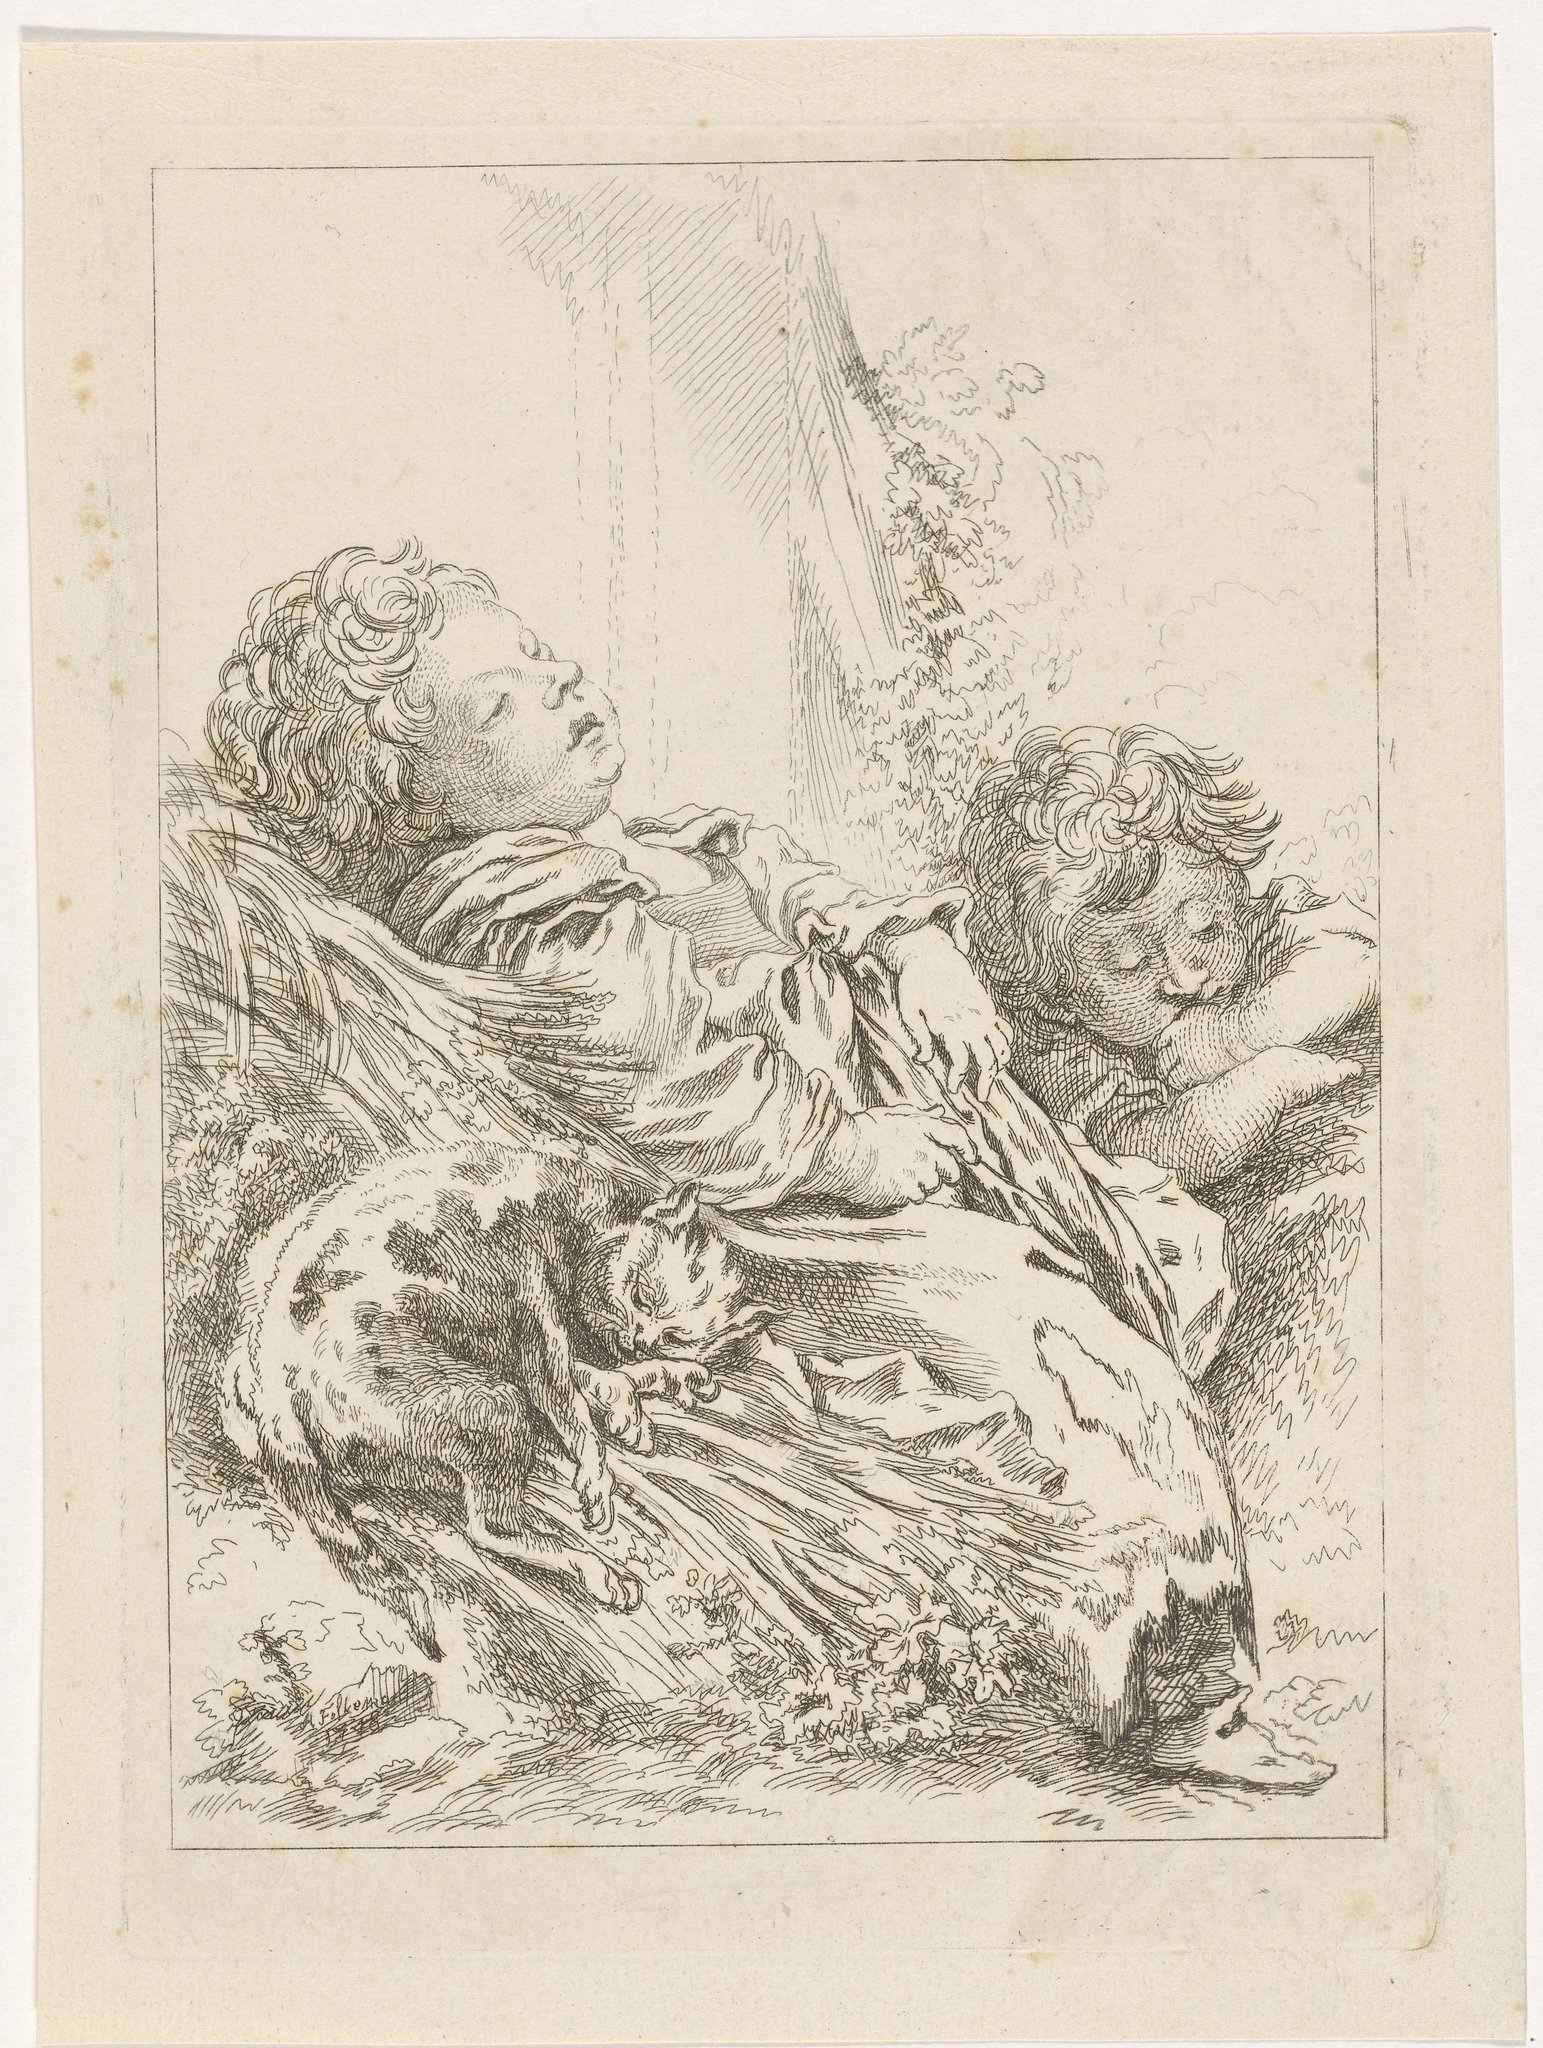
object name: print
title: Twee slapende kinderen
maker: anna folkema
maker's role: draughtsman, print maker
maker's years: 1695-1768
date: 1748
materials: paper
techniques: etching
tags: cat, child, sleeping; unconsciousness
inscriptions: collector's mark: Lugt 240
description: Twee kinderen en een kat liggen naast elkaar te slapen.